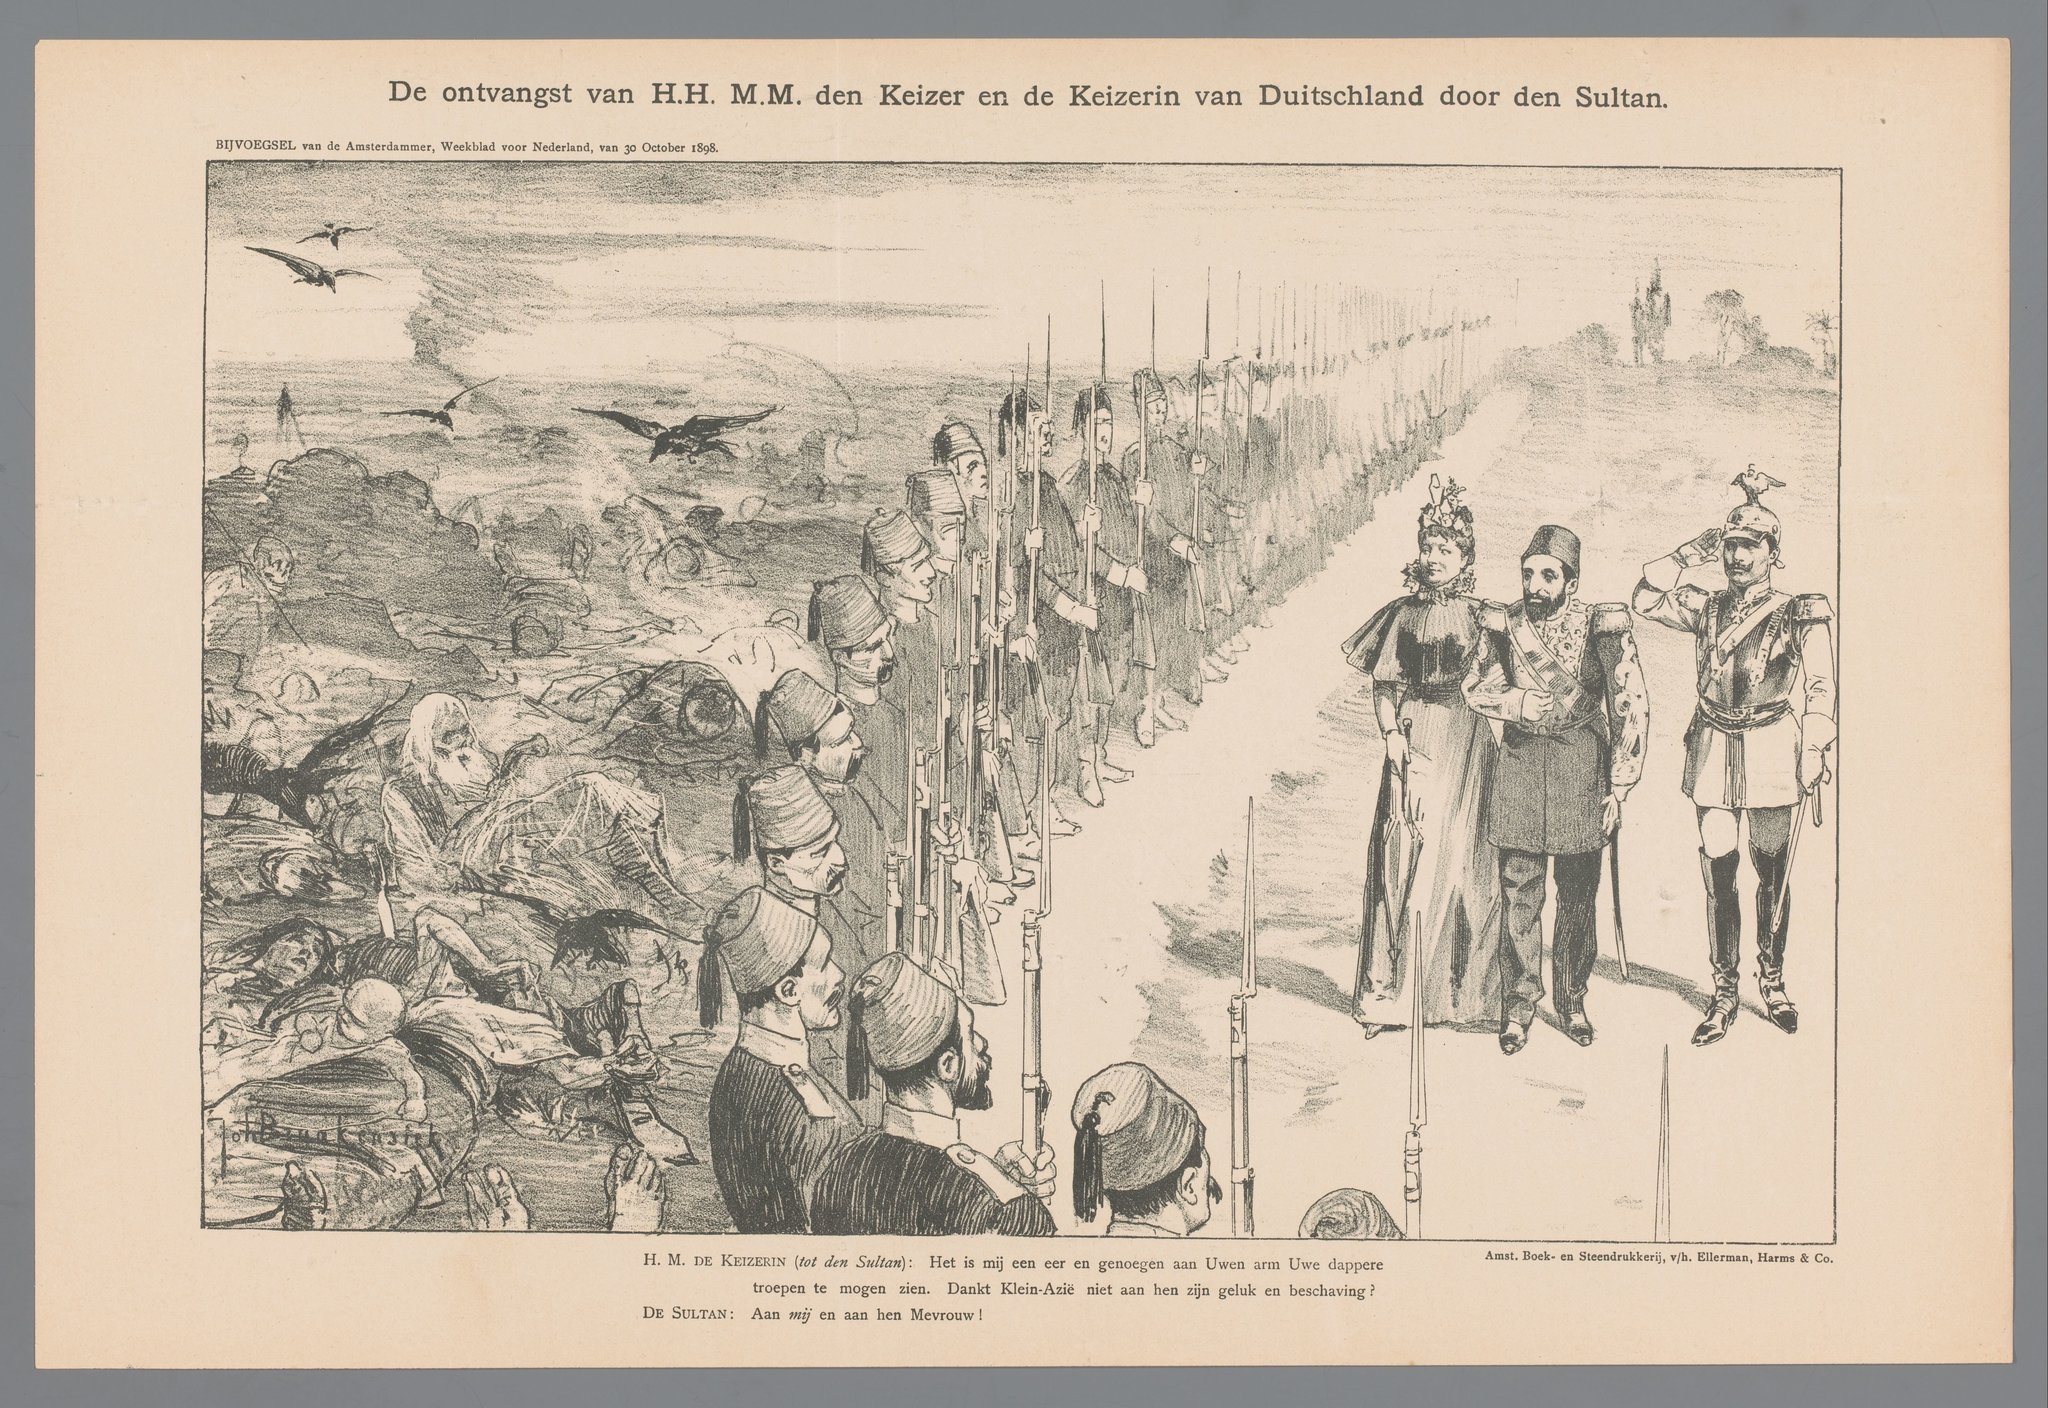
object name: cartoon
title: De ontvangst van H.H. M.M. den Keizer en de Keizerin van Duitschland door den Sultan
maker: johan braakensiek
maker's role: draughtsman, print maker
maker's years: 1858-1940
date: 1898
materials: paper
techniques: lithograph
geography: amsterdam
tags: wilhelm ii (keizer van duitsland), augusta victoria (keizerin van duitsland), historical persons - bb - woman, historical persons, land forces, political caricatures and satires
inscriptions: date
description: Prent uit het bijvoegsel van: De Amsterdammer. Weekblad voor Nederland, 30 oktober 1898.